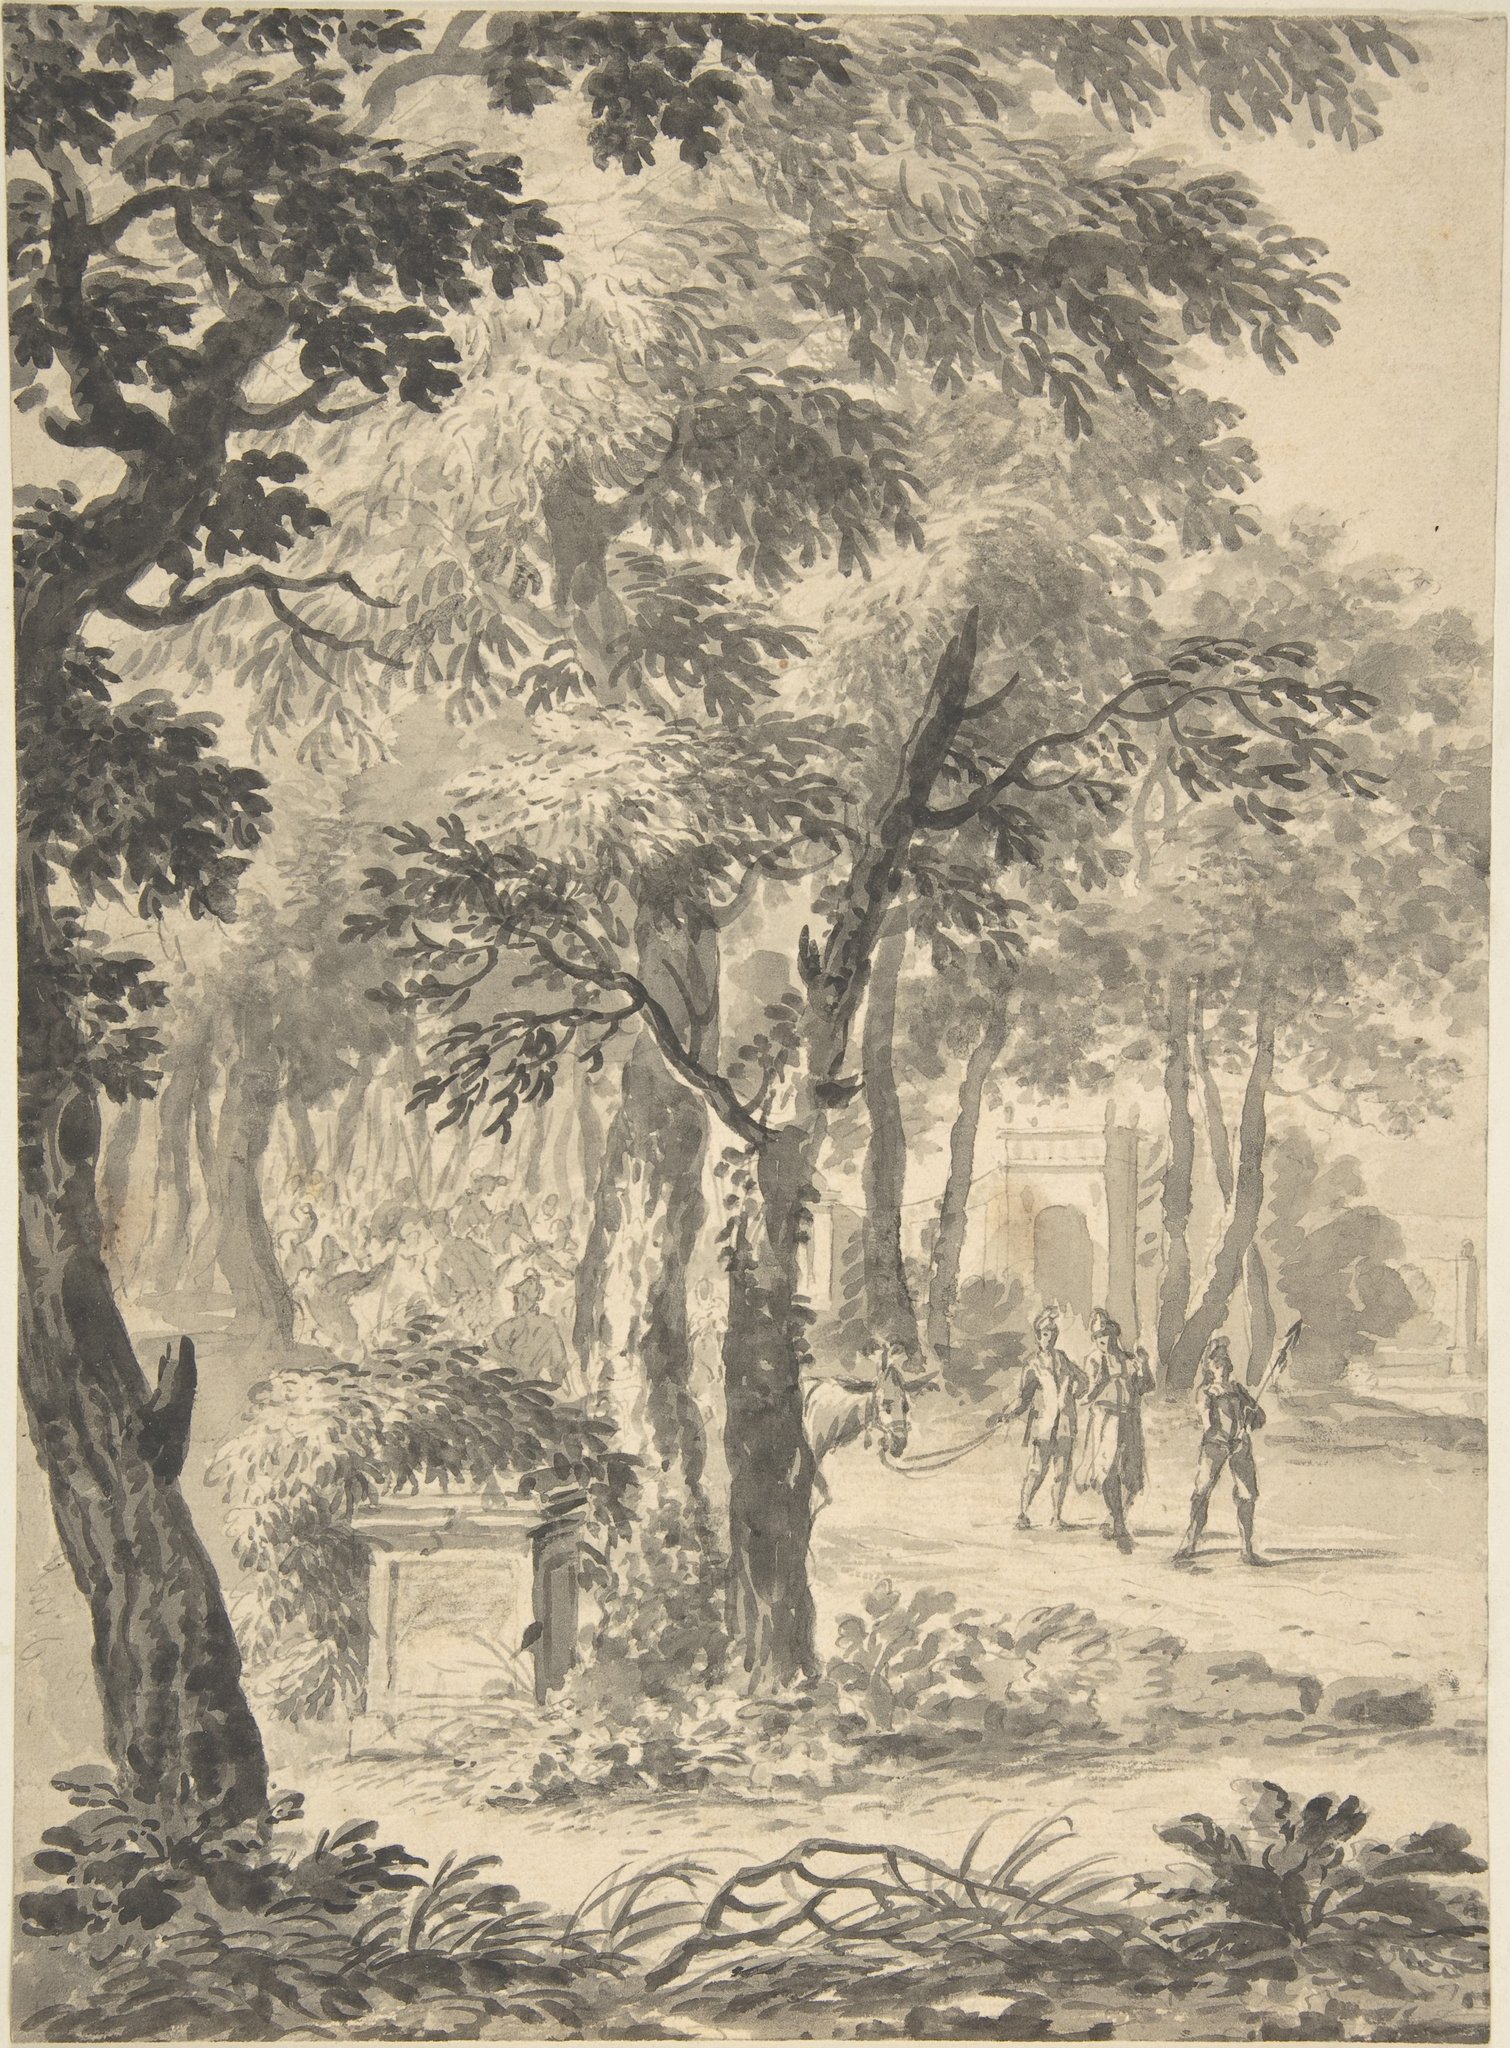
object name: drawing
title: Picturesque Landscape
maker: anonymous, british, 18th century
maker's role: artist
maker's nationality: british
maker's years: 1700-1800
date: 1701-1800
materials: graphite, ink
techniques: brush, pen, wash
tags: landscapes,trees